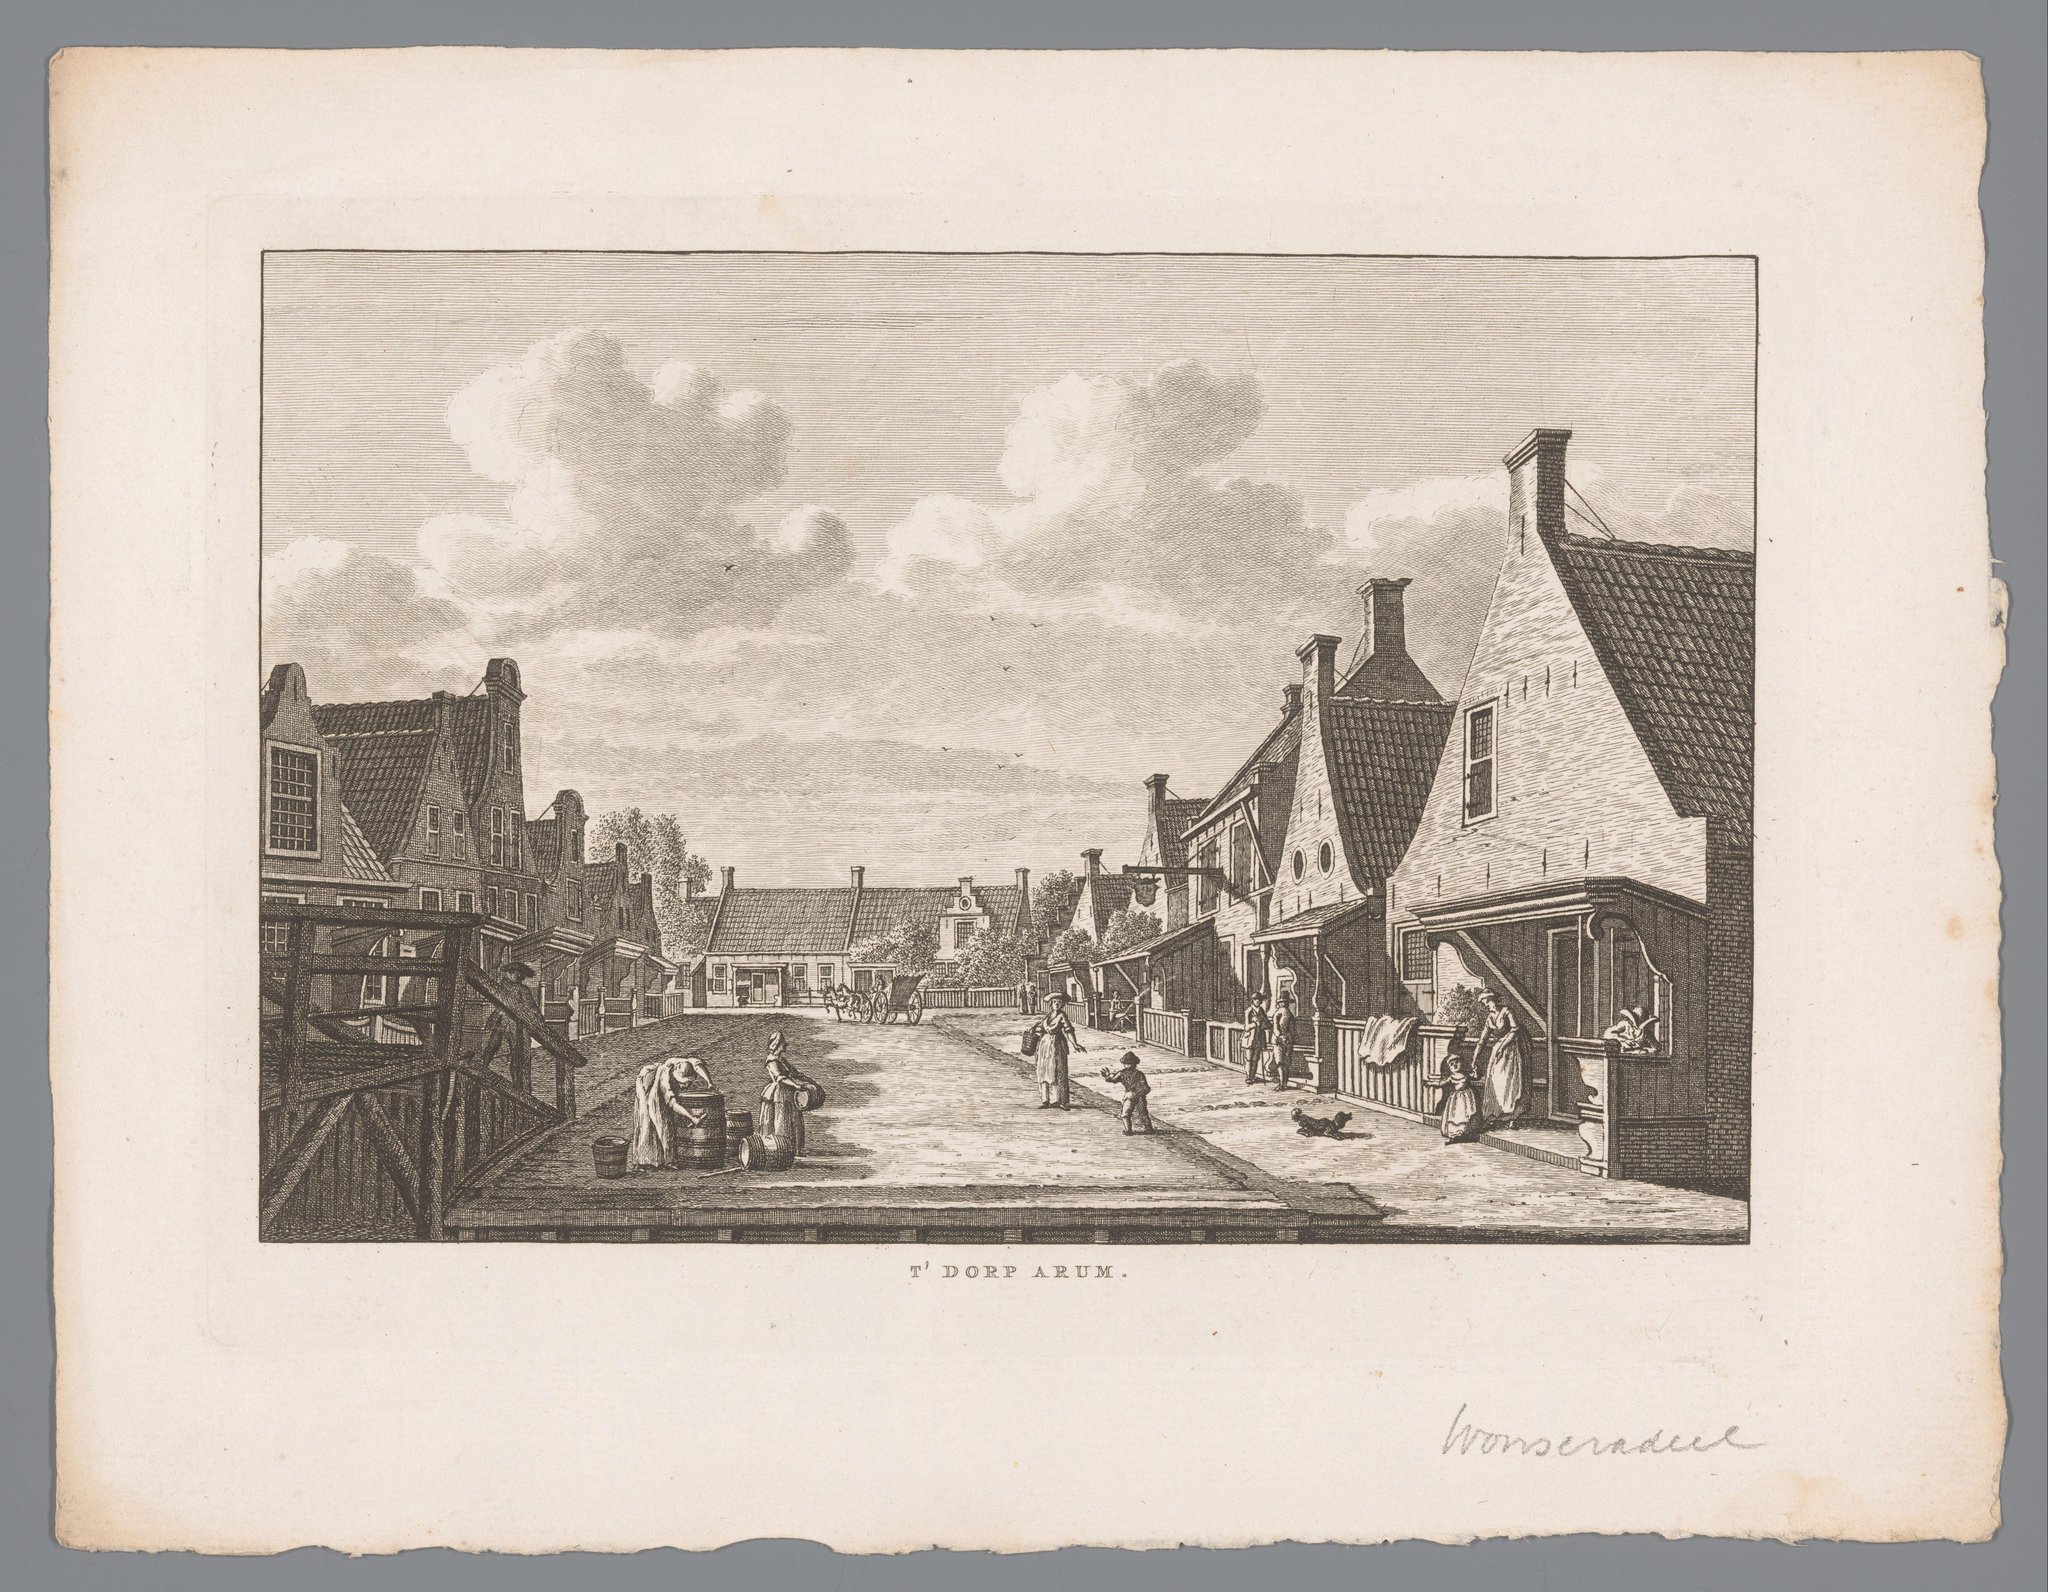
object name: print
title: Dorpsgezicht te Arum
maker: carel frederik bendorp (i)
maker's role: print maker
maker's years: 1736-1814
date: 1786-1792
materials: paper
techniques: etching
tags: village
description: Prent uit: Vaderlandsche gezichten, of afbeeldingen van den tegenwoordigen staat der Vereenigde Nederlanden (…). Amsterdam: Hendrik Gartman, Willem Vermandel en Jan Willem Smit, 1786-1792. Uitgegeven in afleveringen met ieder een eigen bifolium en inhoudsopgave. Alle prenten in deze publicatie zijn gegraveerd door Carel Frederik Bendorp (I) en, in de meeste gevallen, gebaseerd op tekeningen van Jan Bulthuis.